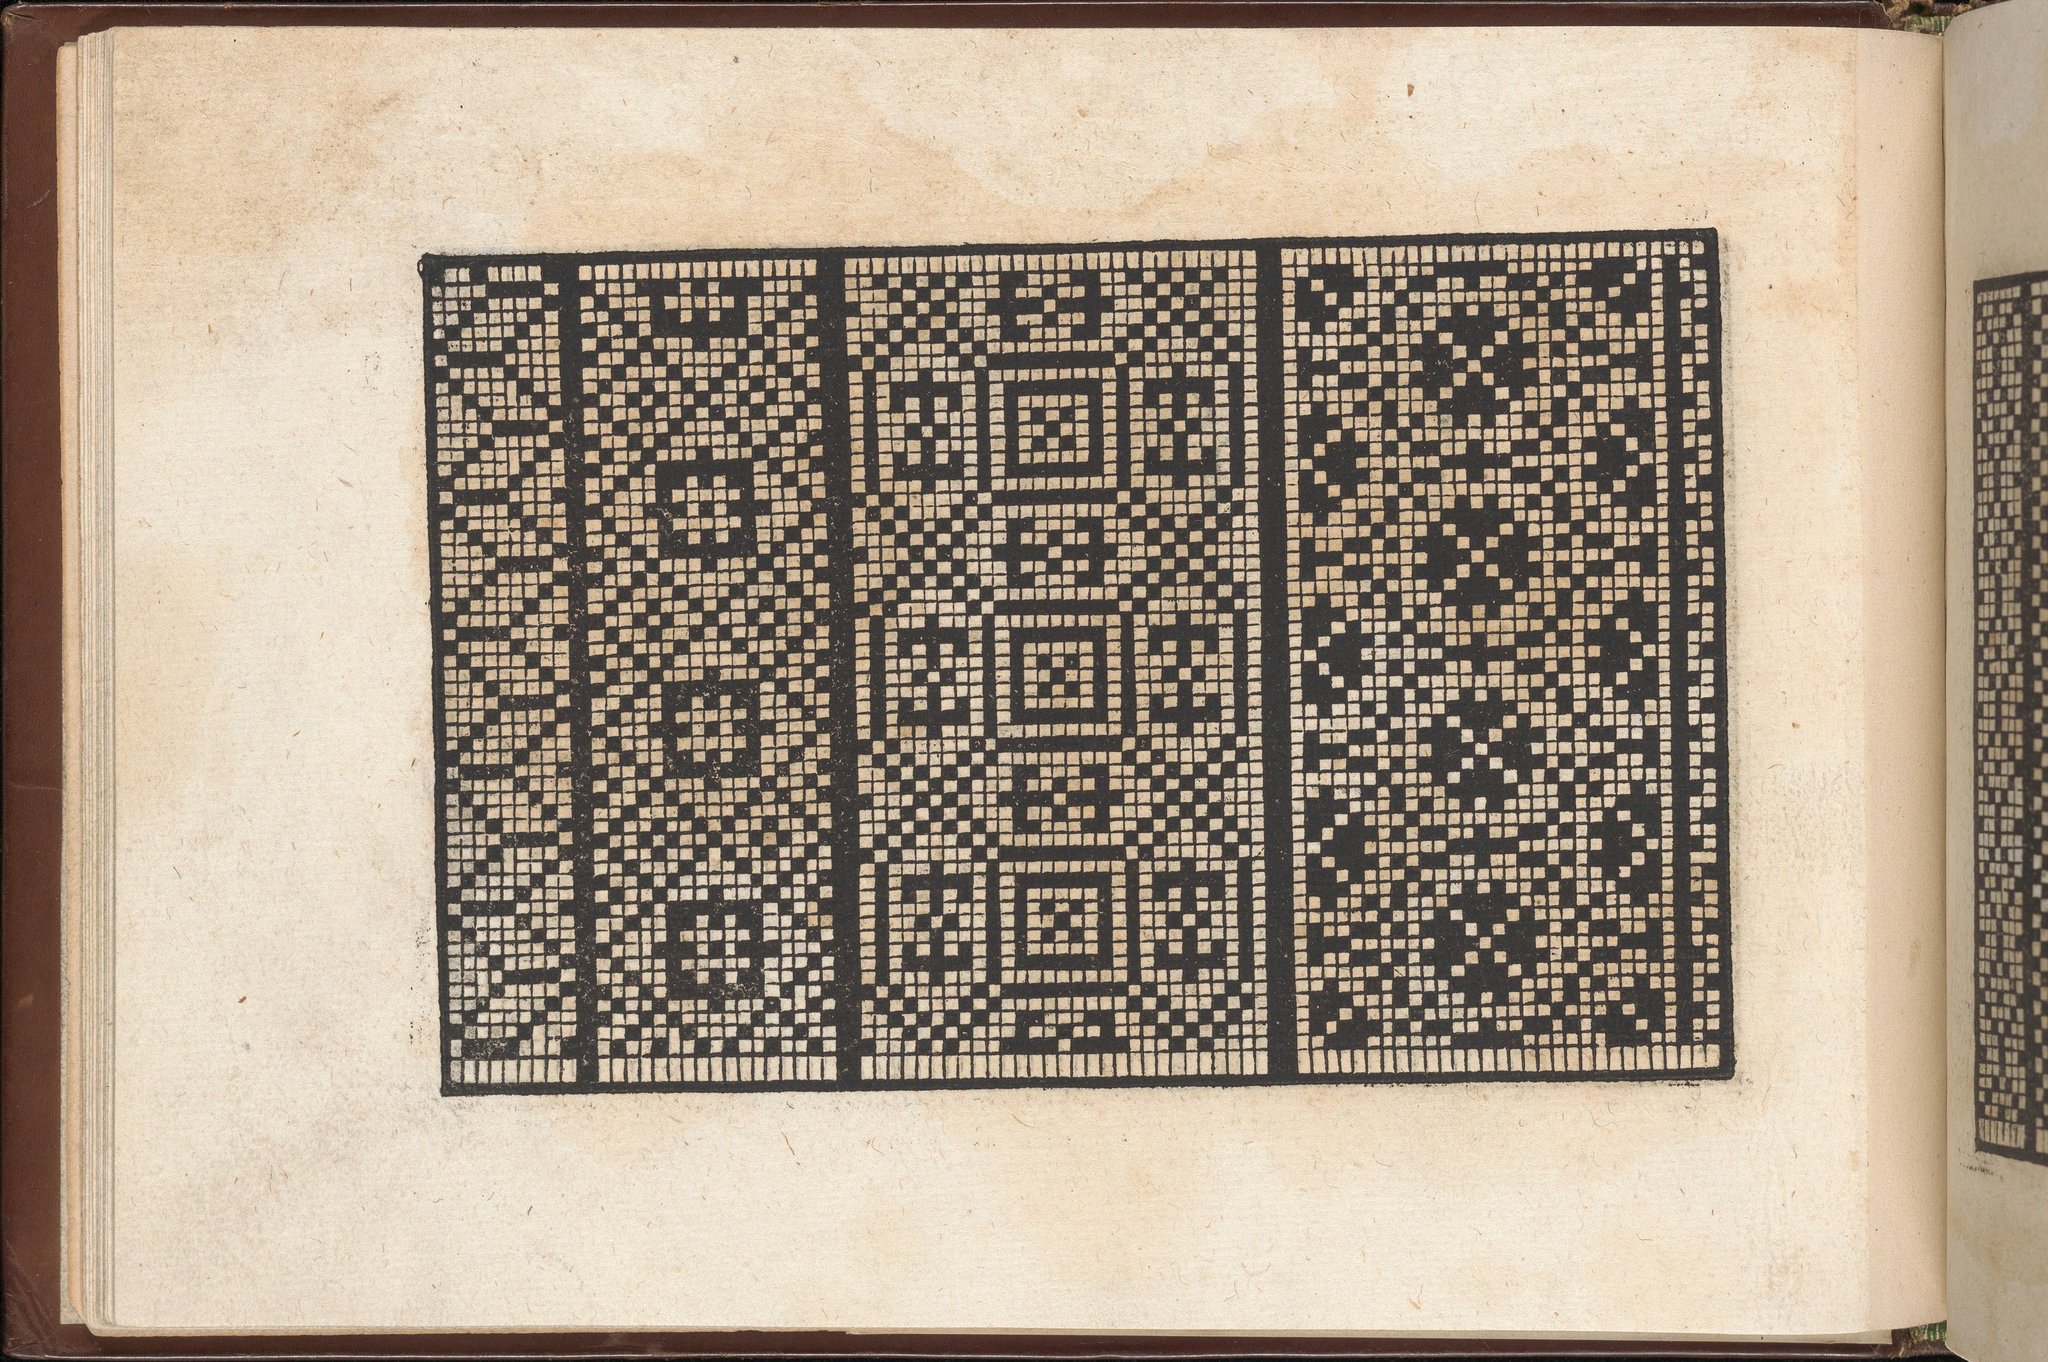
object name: book print ornament architecture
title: Page from Eyn Newe kunstlich moetdelboech alle kunst (Page 14v)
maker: peter quentel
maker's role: publisher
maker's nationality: german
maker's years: 1500-1550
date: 1532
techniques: woodcut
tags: ornament